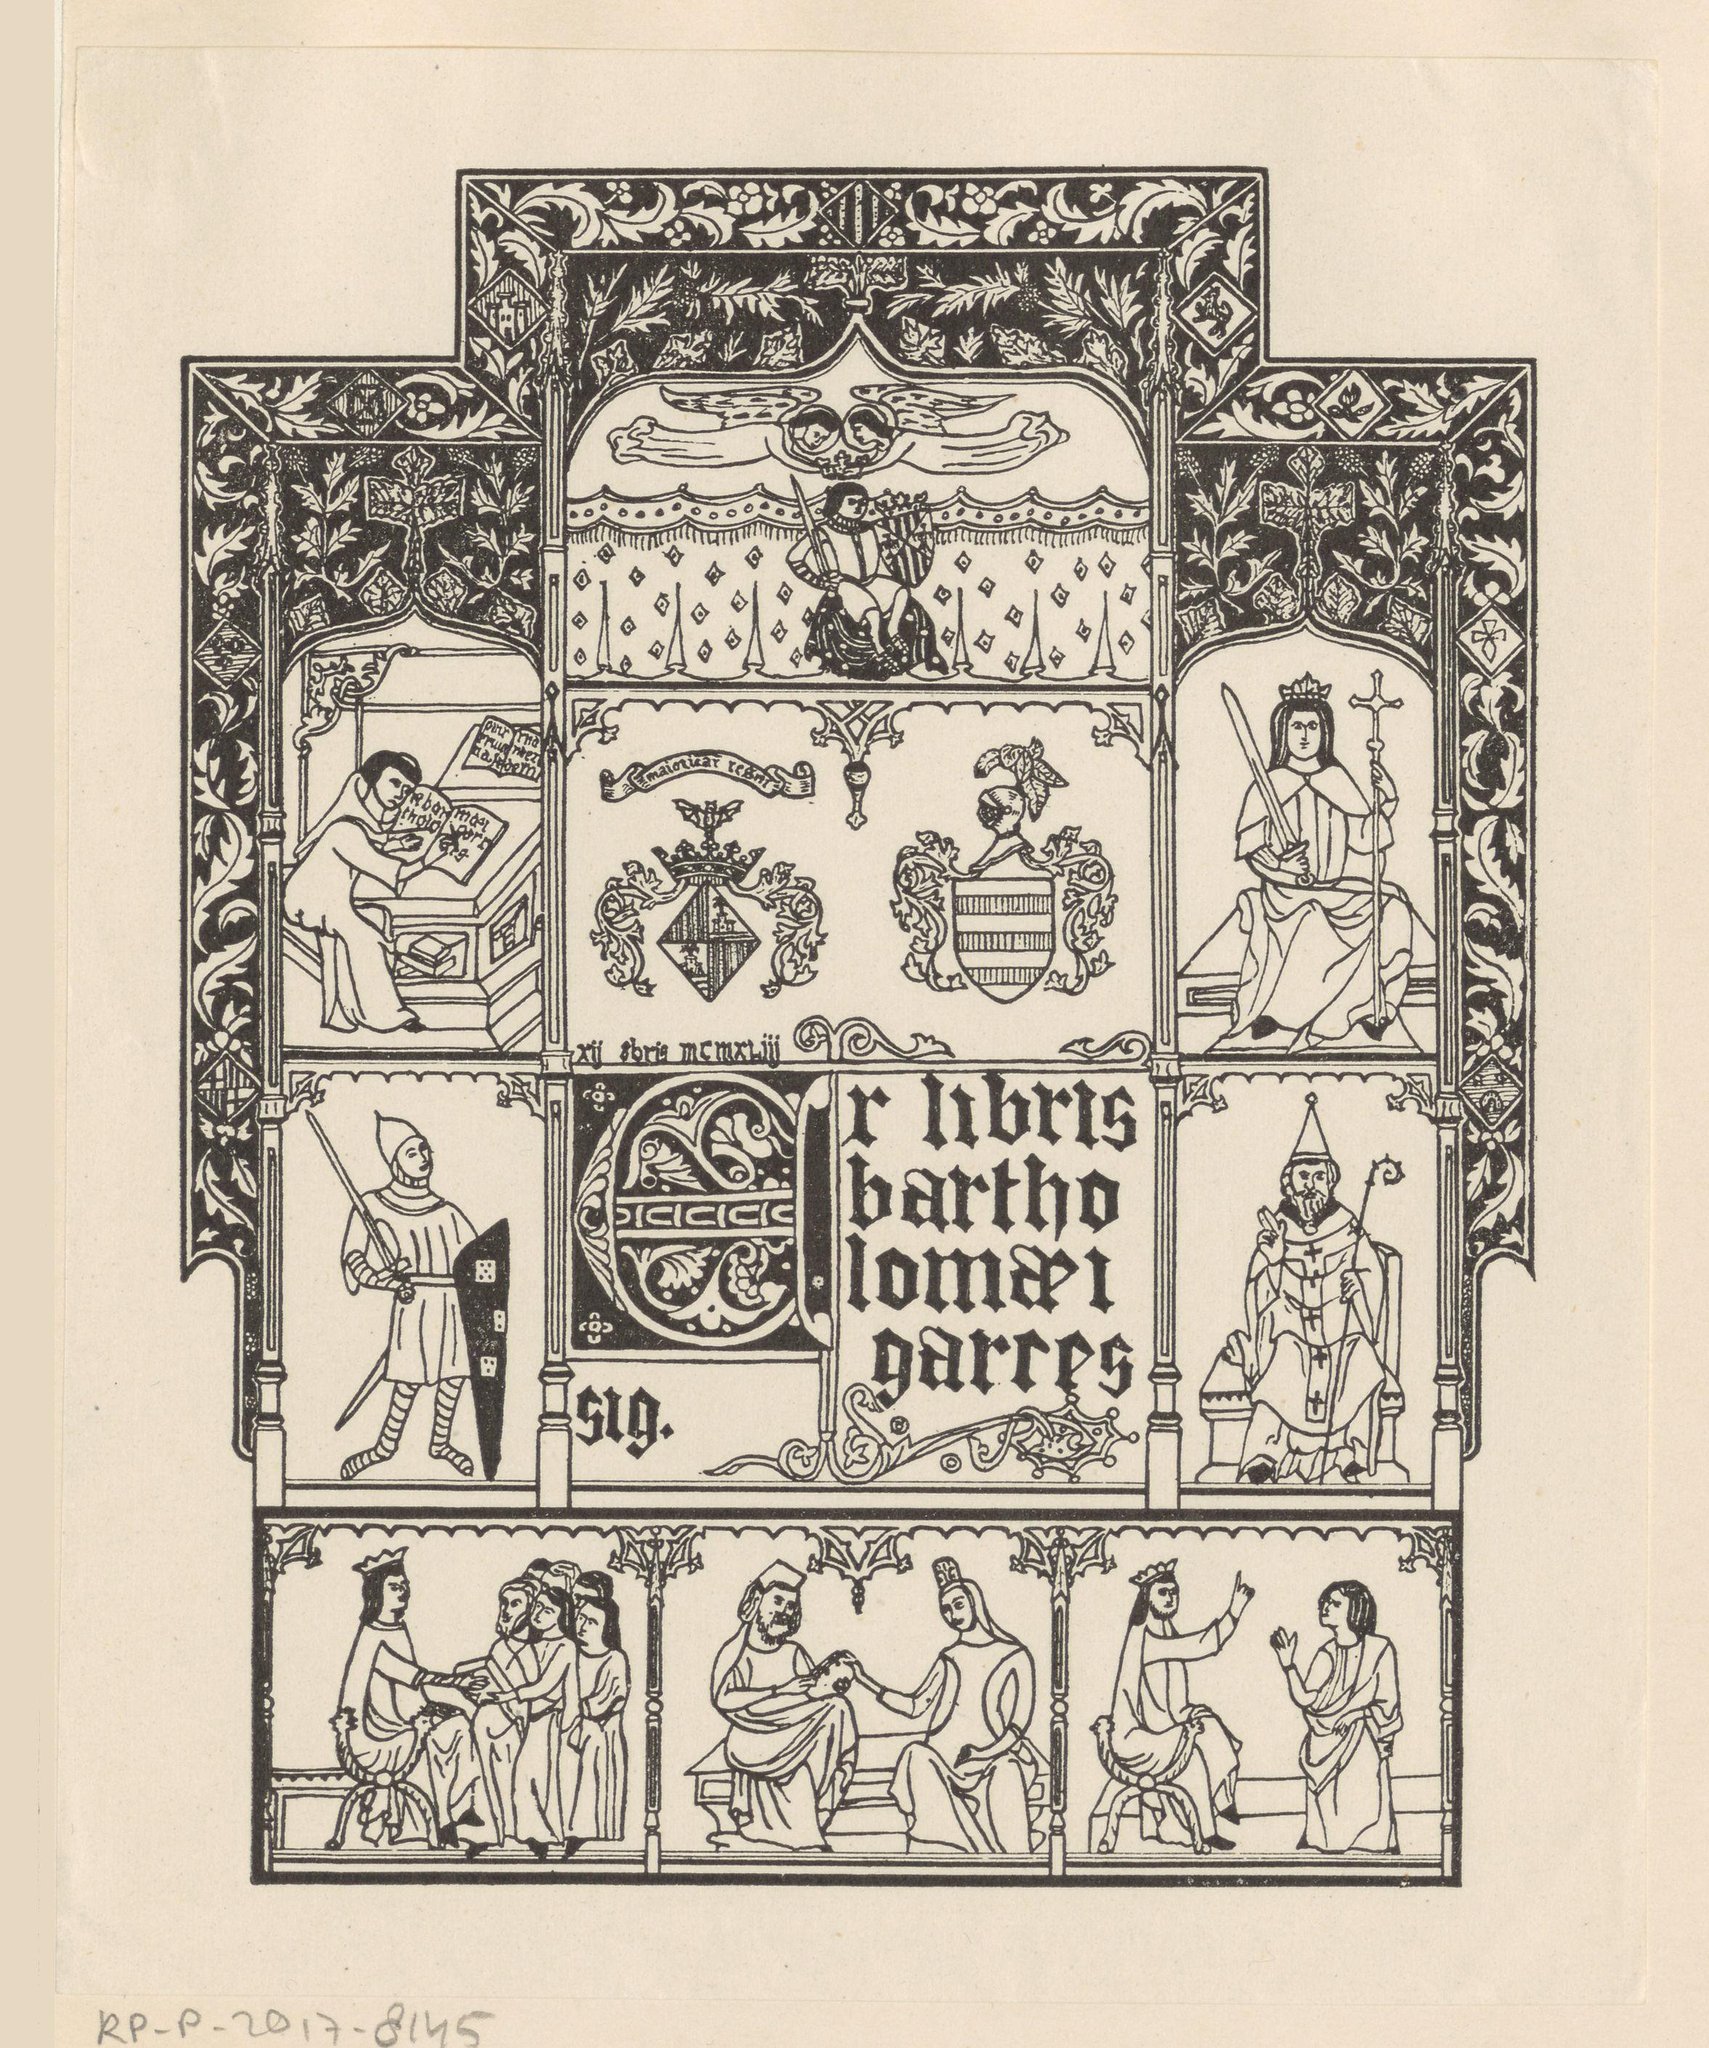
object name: bookplate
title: Ex libris van Bartholomaei Garcés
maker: Anonymous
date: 1943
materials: paper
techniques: printing block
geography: spain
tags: historical costume, ruler, sovereign, angels, armorial bearing, heraldry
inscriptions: date